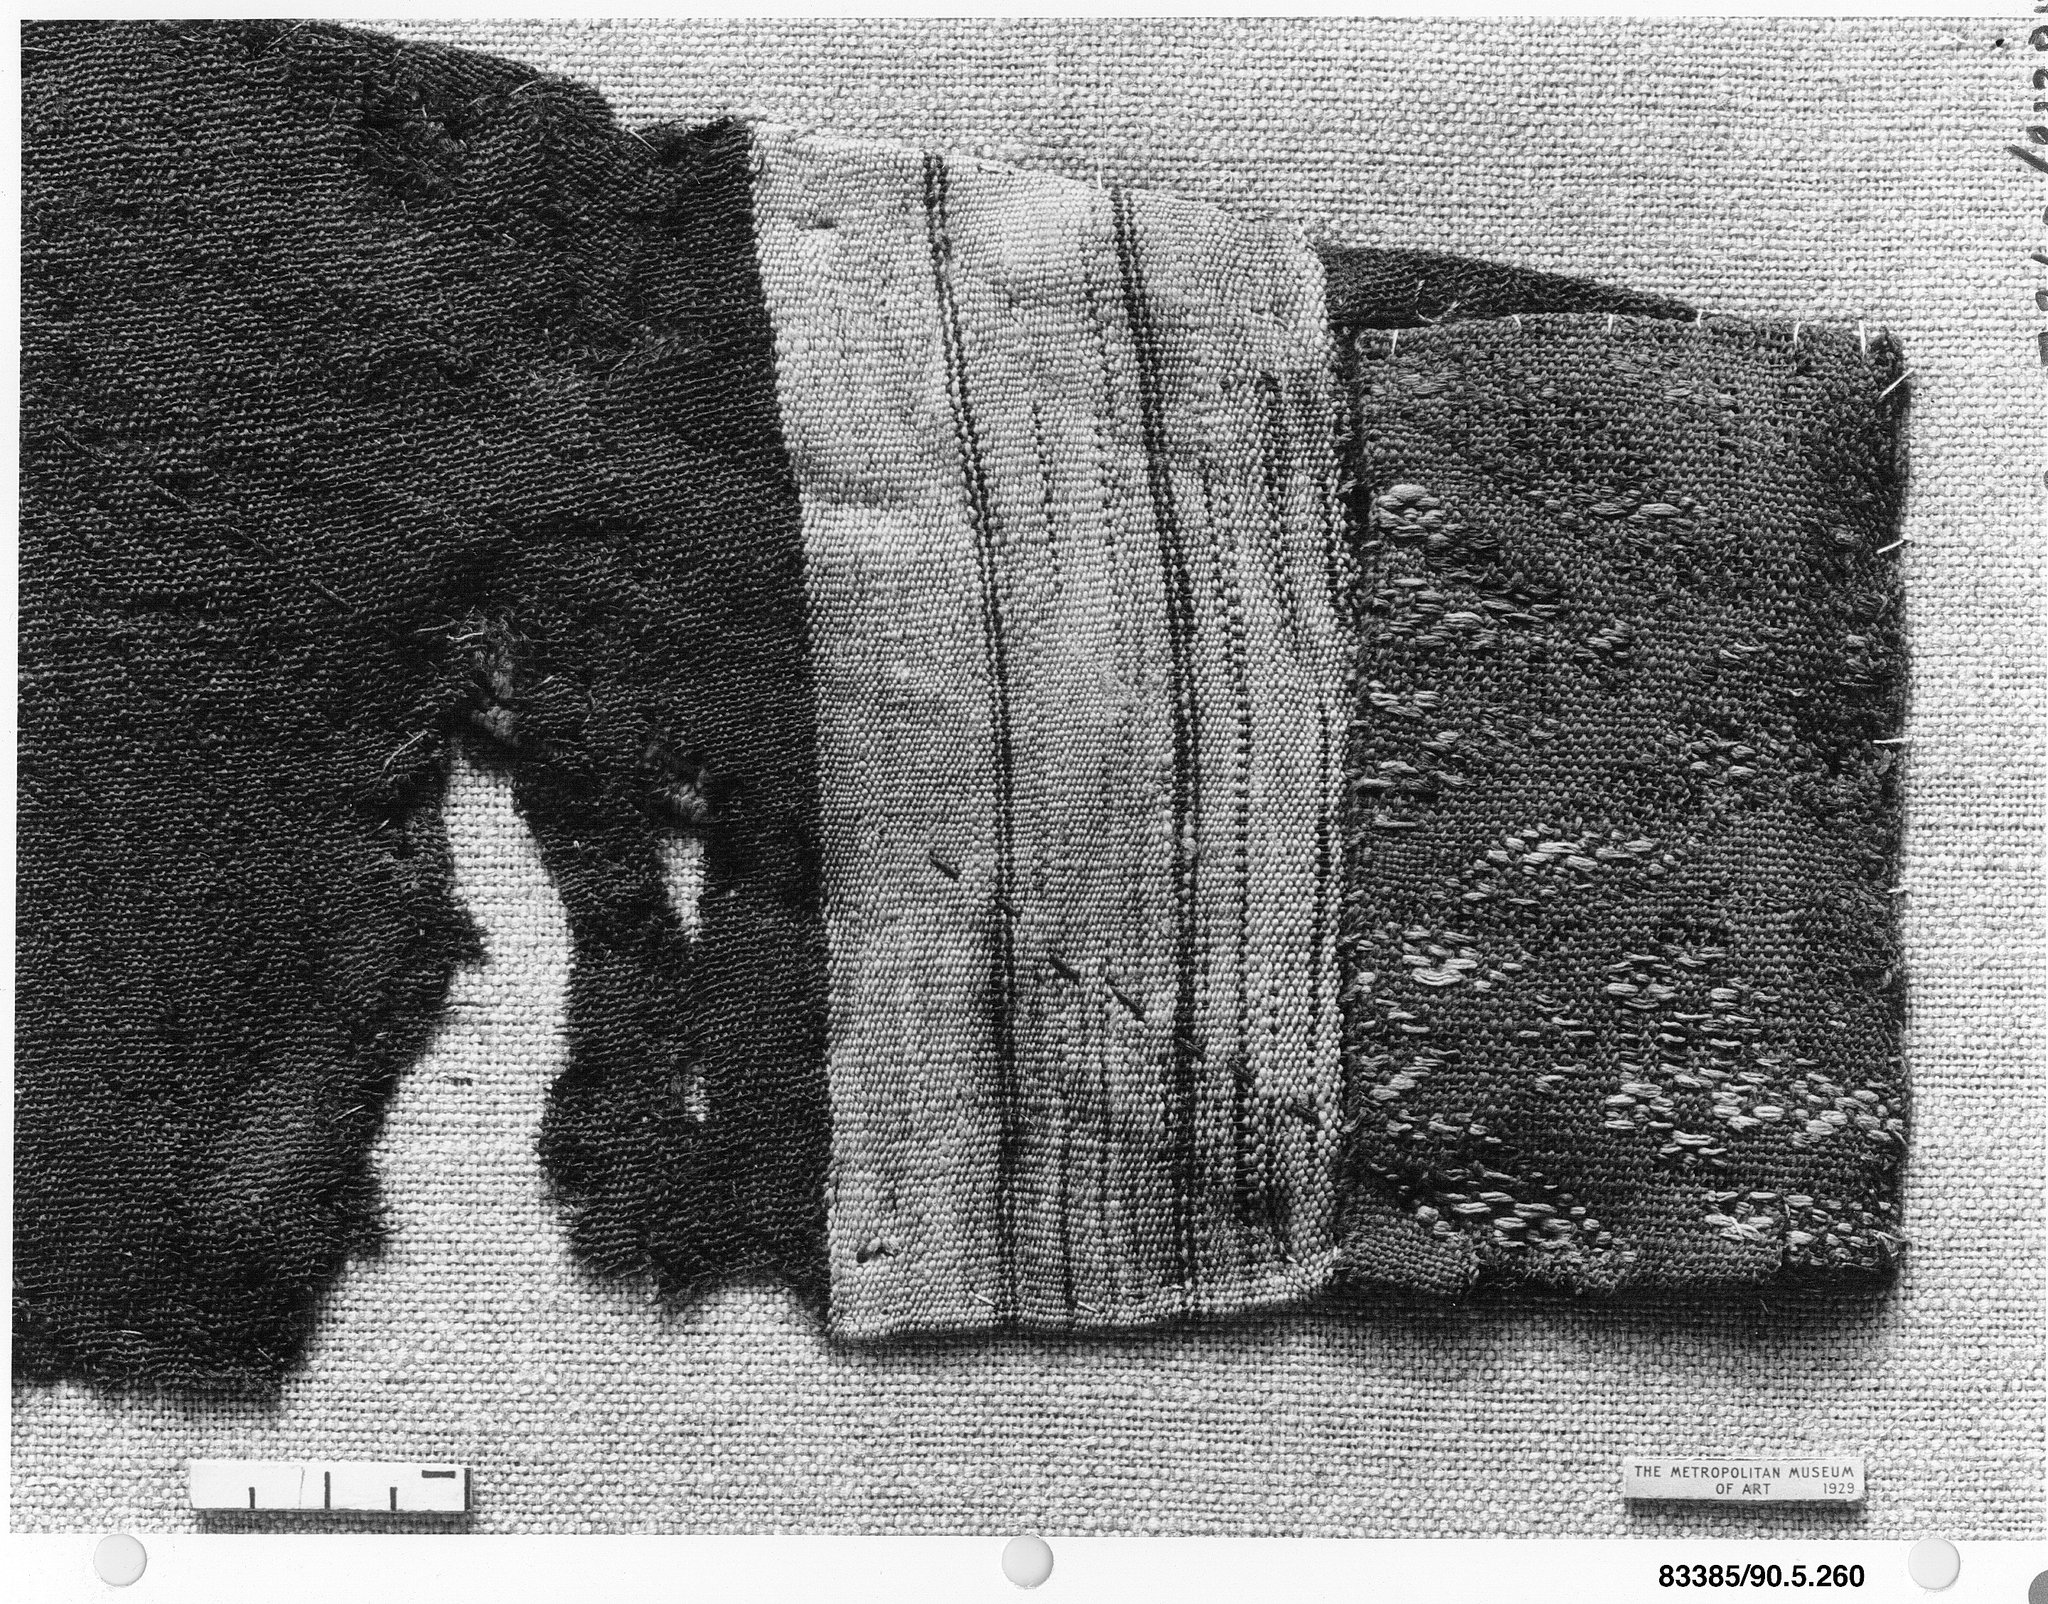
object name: textile fragment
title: Blue Sleeve Fragment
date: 501-900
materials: linen, wool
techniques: weave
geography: egypt